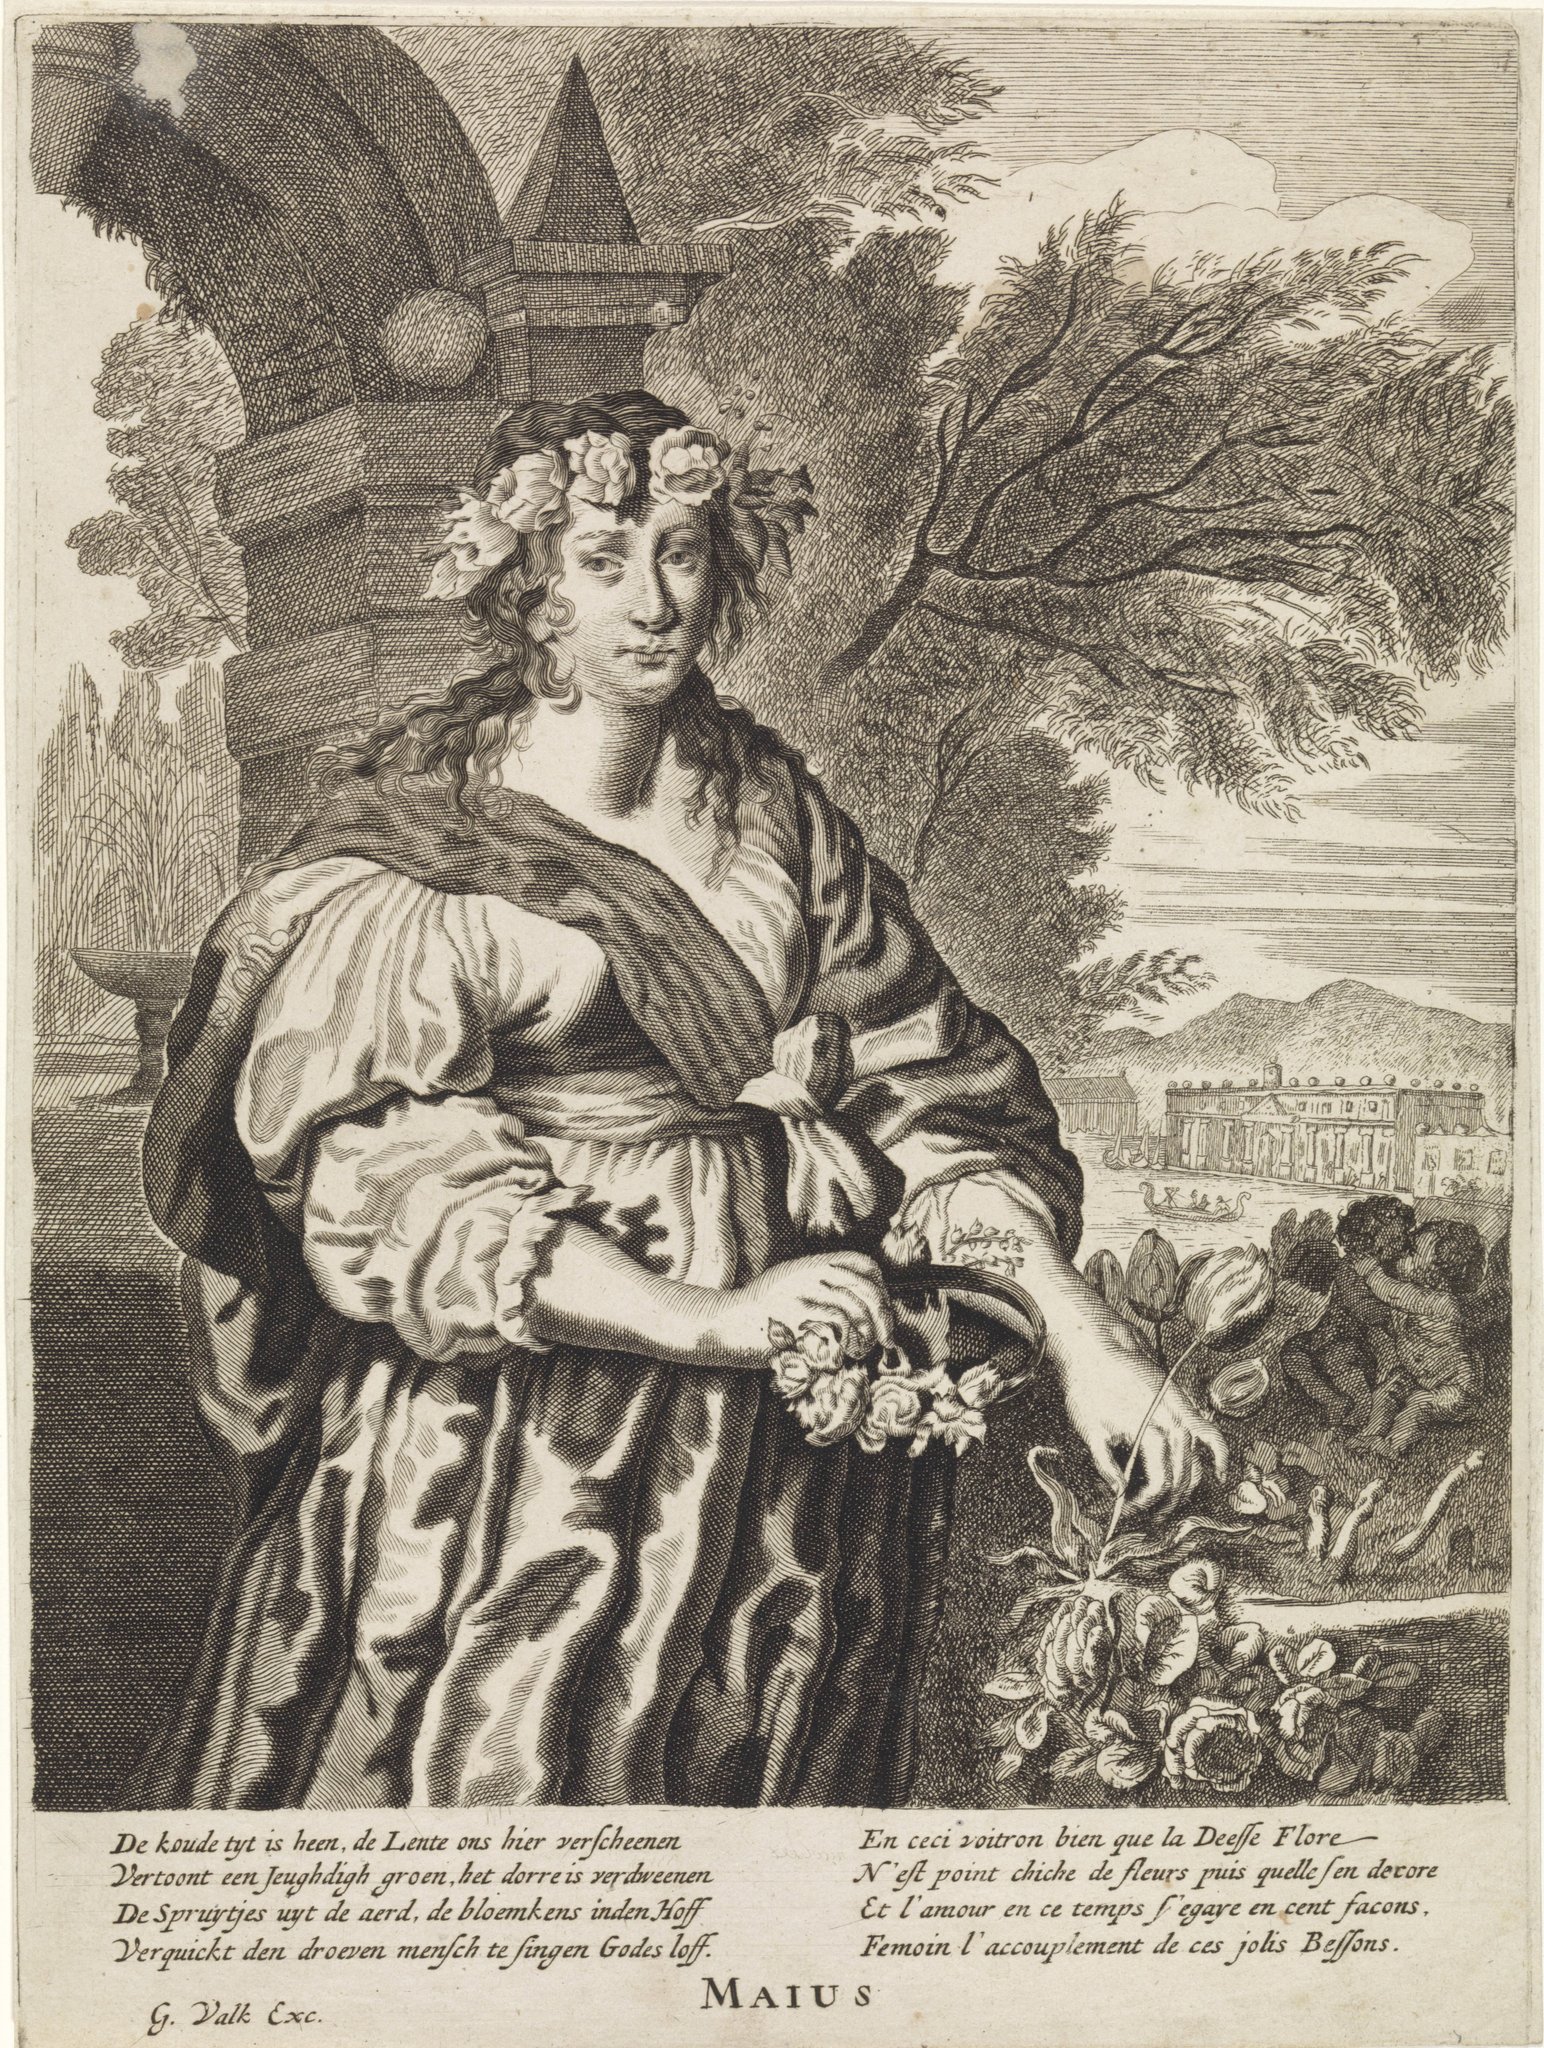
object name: print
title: De twaalf maanden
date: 1670-1726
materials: paper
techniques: engraving, etching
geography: amsterdam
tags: may; 'maggio' (ripa), gemini (zodiacal sign of may), flowers: tulip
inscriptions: collector's mark: Lugt 2228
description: Voor een poortgebouw staat een jonge vrouw, die een bloemenkrans in wording in de hand houdt, terwijl ze een tulp plukt. In het bloemenperk bloeien verder rozen en asperges. De tweeling, het sterrenbeeld van deze maand, omhelst en kust elkaar. Onder de voorstelling een gedicht in het Nederlands van Joost van den Vondel en een vers in het Frans.